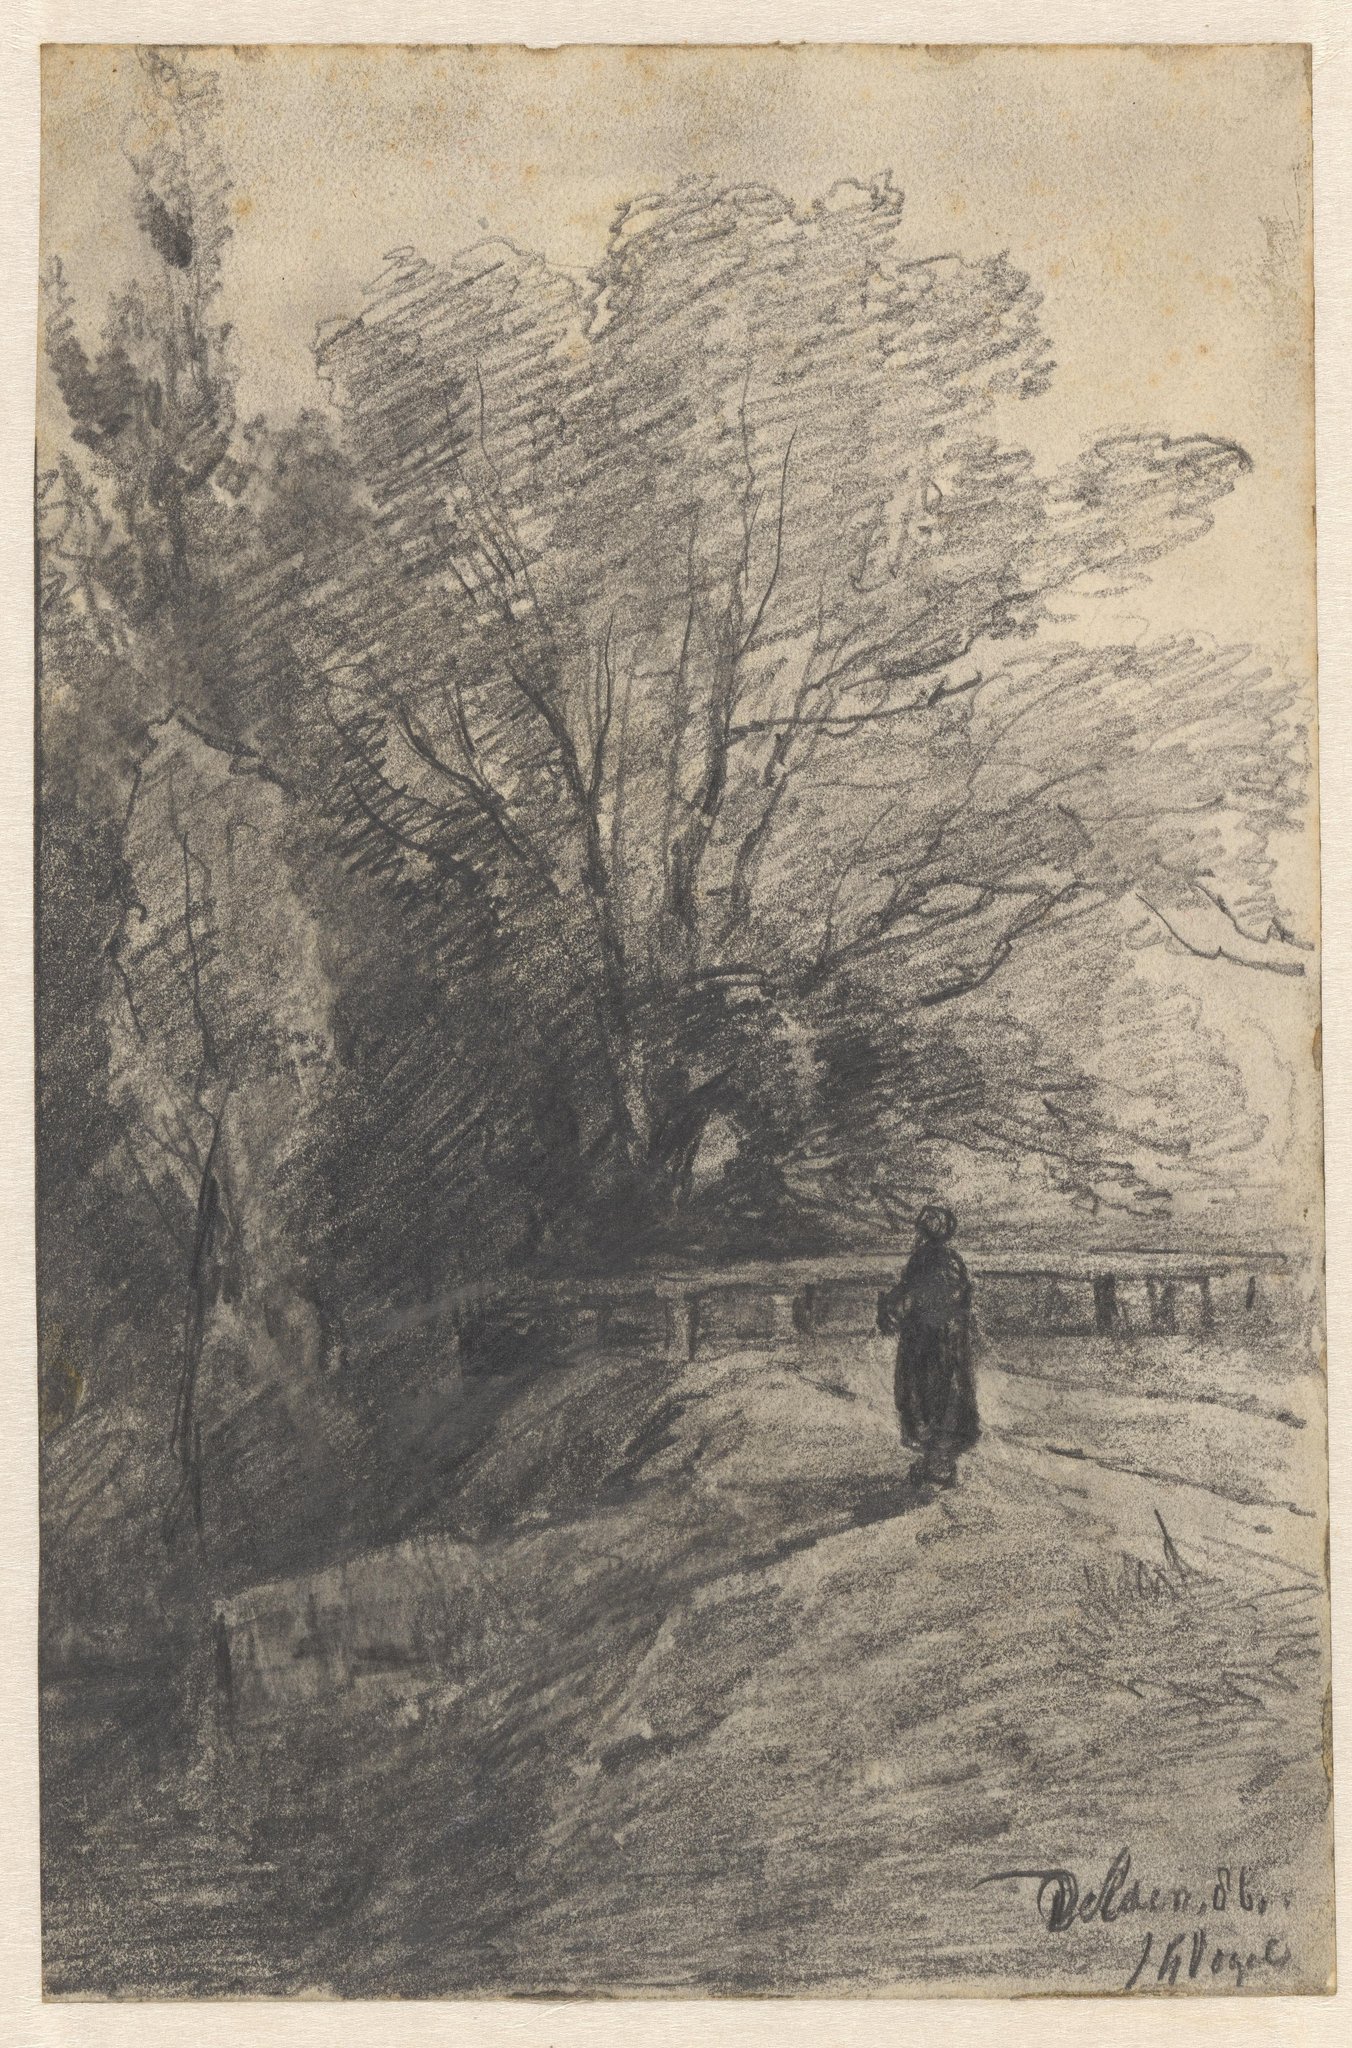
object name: drawing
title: Vrouw in een landschap bij Delden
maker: johannes gijsbert vogel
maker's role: draughtsman, painter, print maker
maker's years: 1828-1915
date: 1886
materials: paper, pencil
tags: landscapes (+ landscape with figures, staffage)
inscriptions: collector's mark: Lugt 1181b, date and inscription: ‘Delden, 86.’